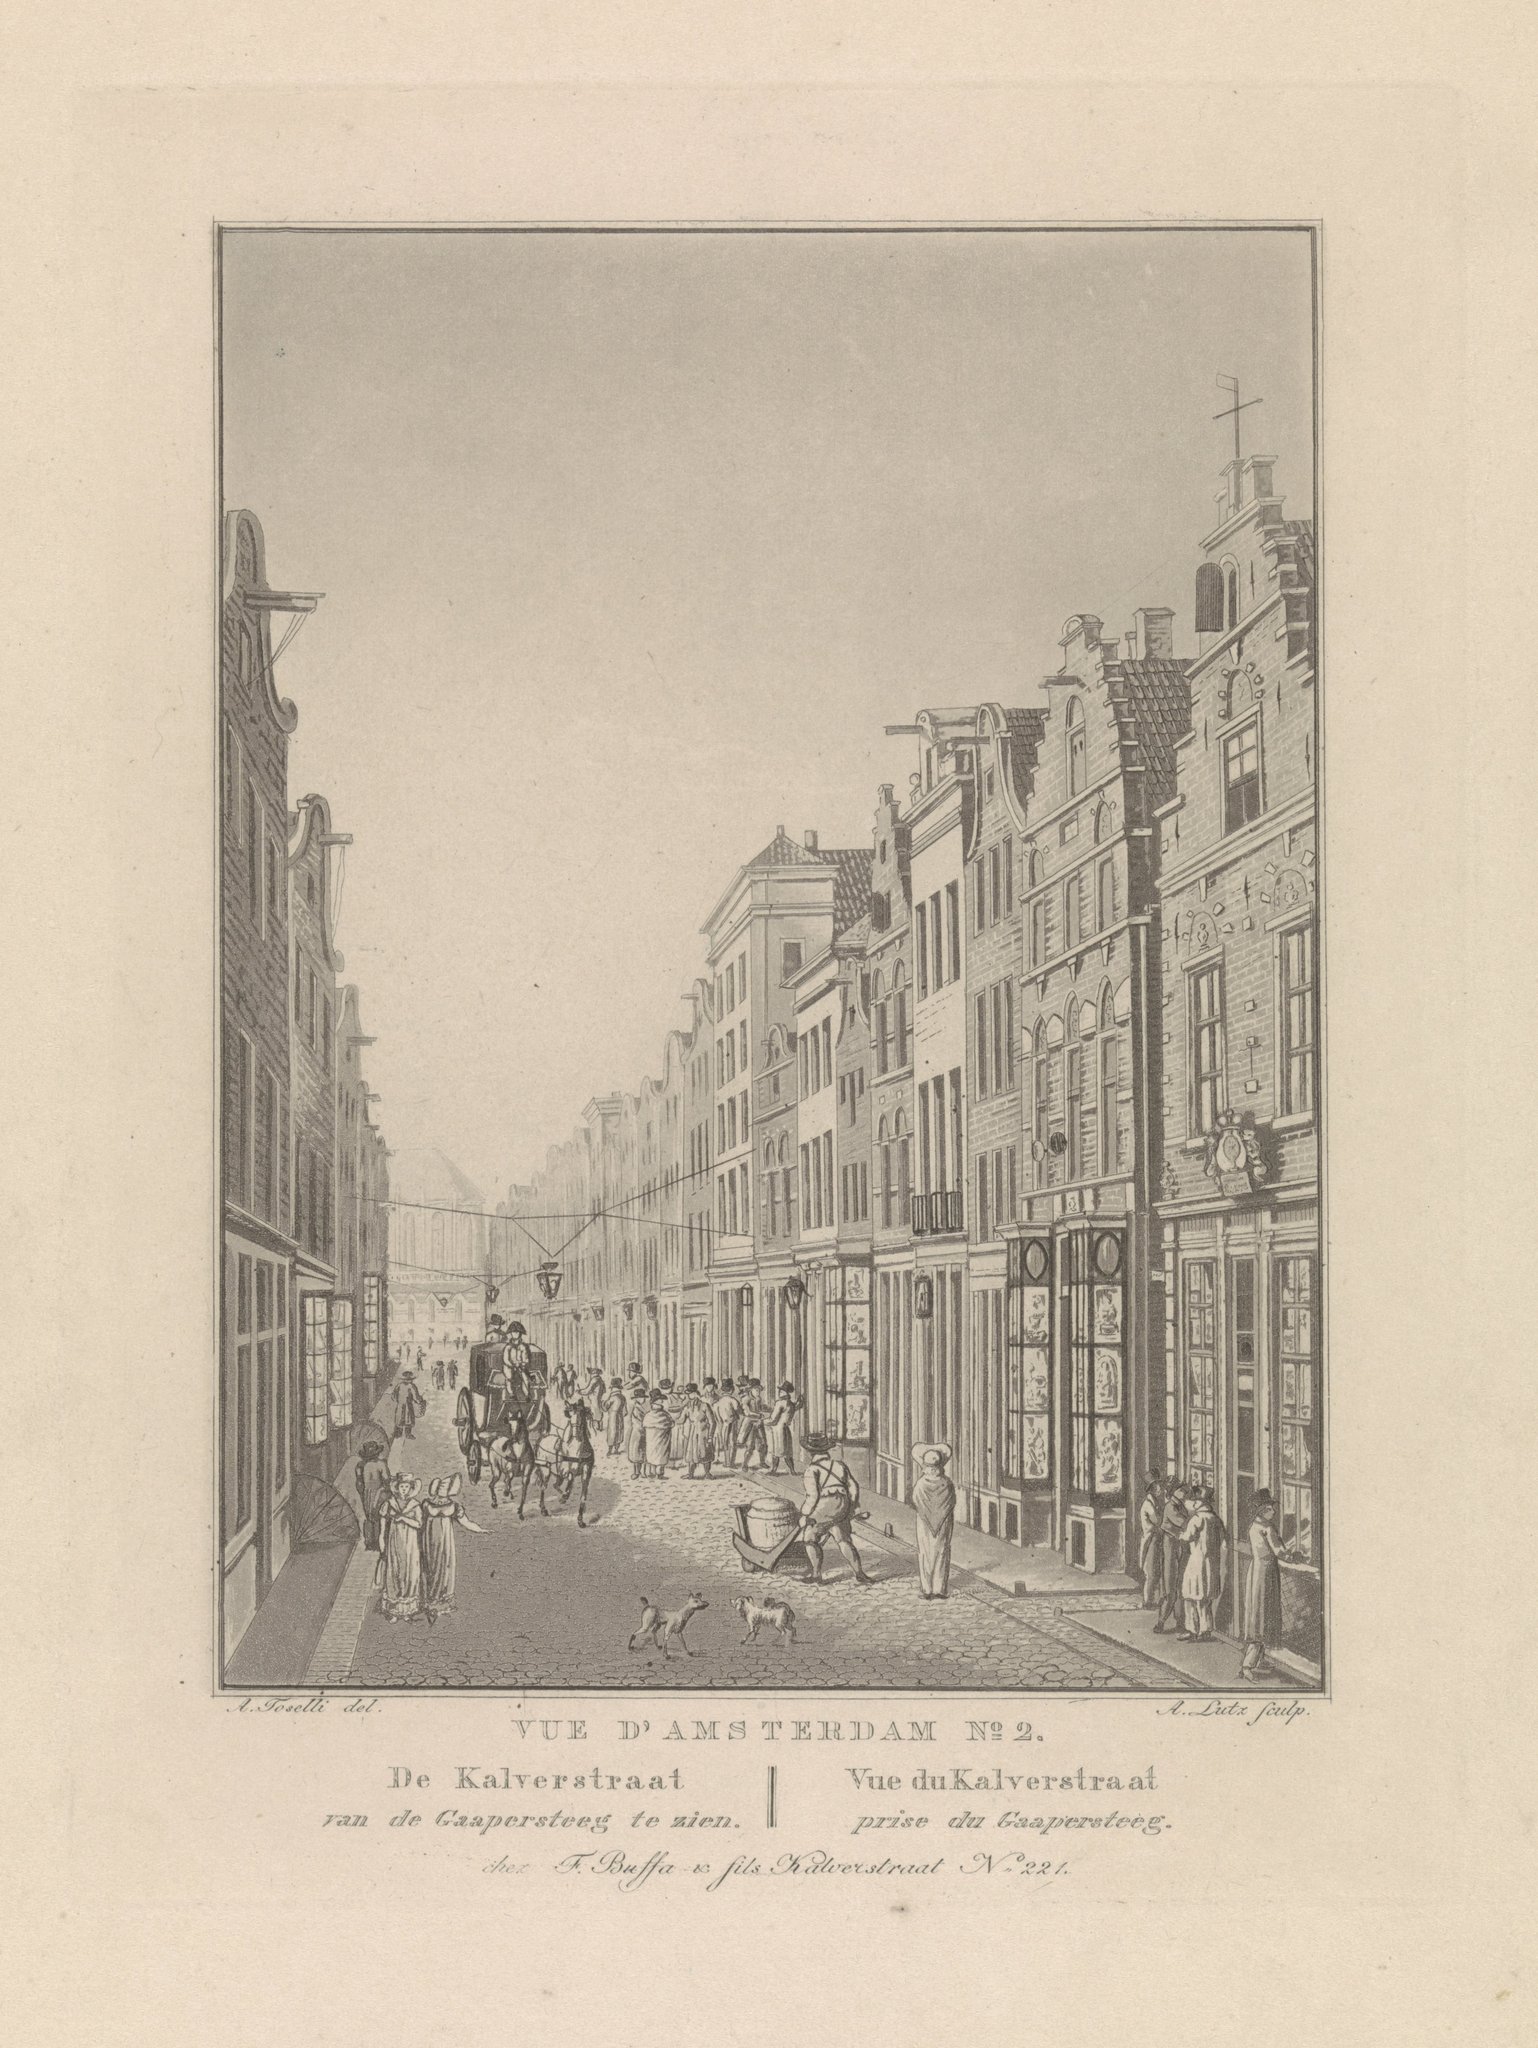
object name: print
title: Gezichten op Amsterdam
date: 1825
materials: paper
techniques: aquatint, etching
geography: amsterdam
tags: street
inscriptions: collector's mark: Lugt 2233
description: De Kalverstraat te Amsterdam, gezien naar de Dam.